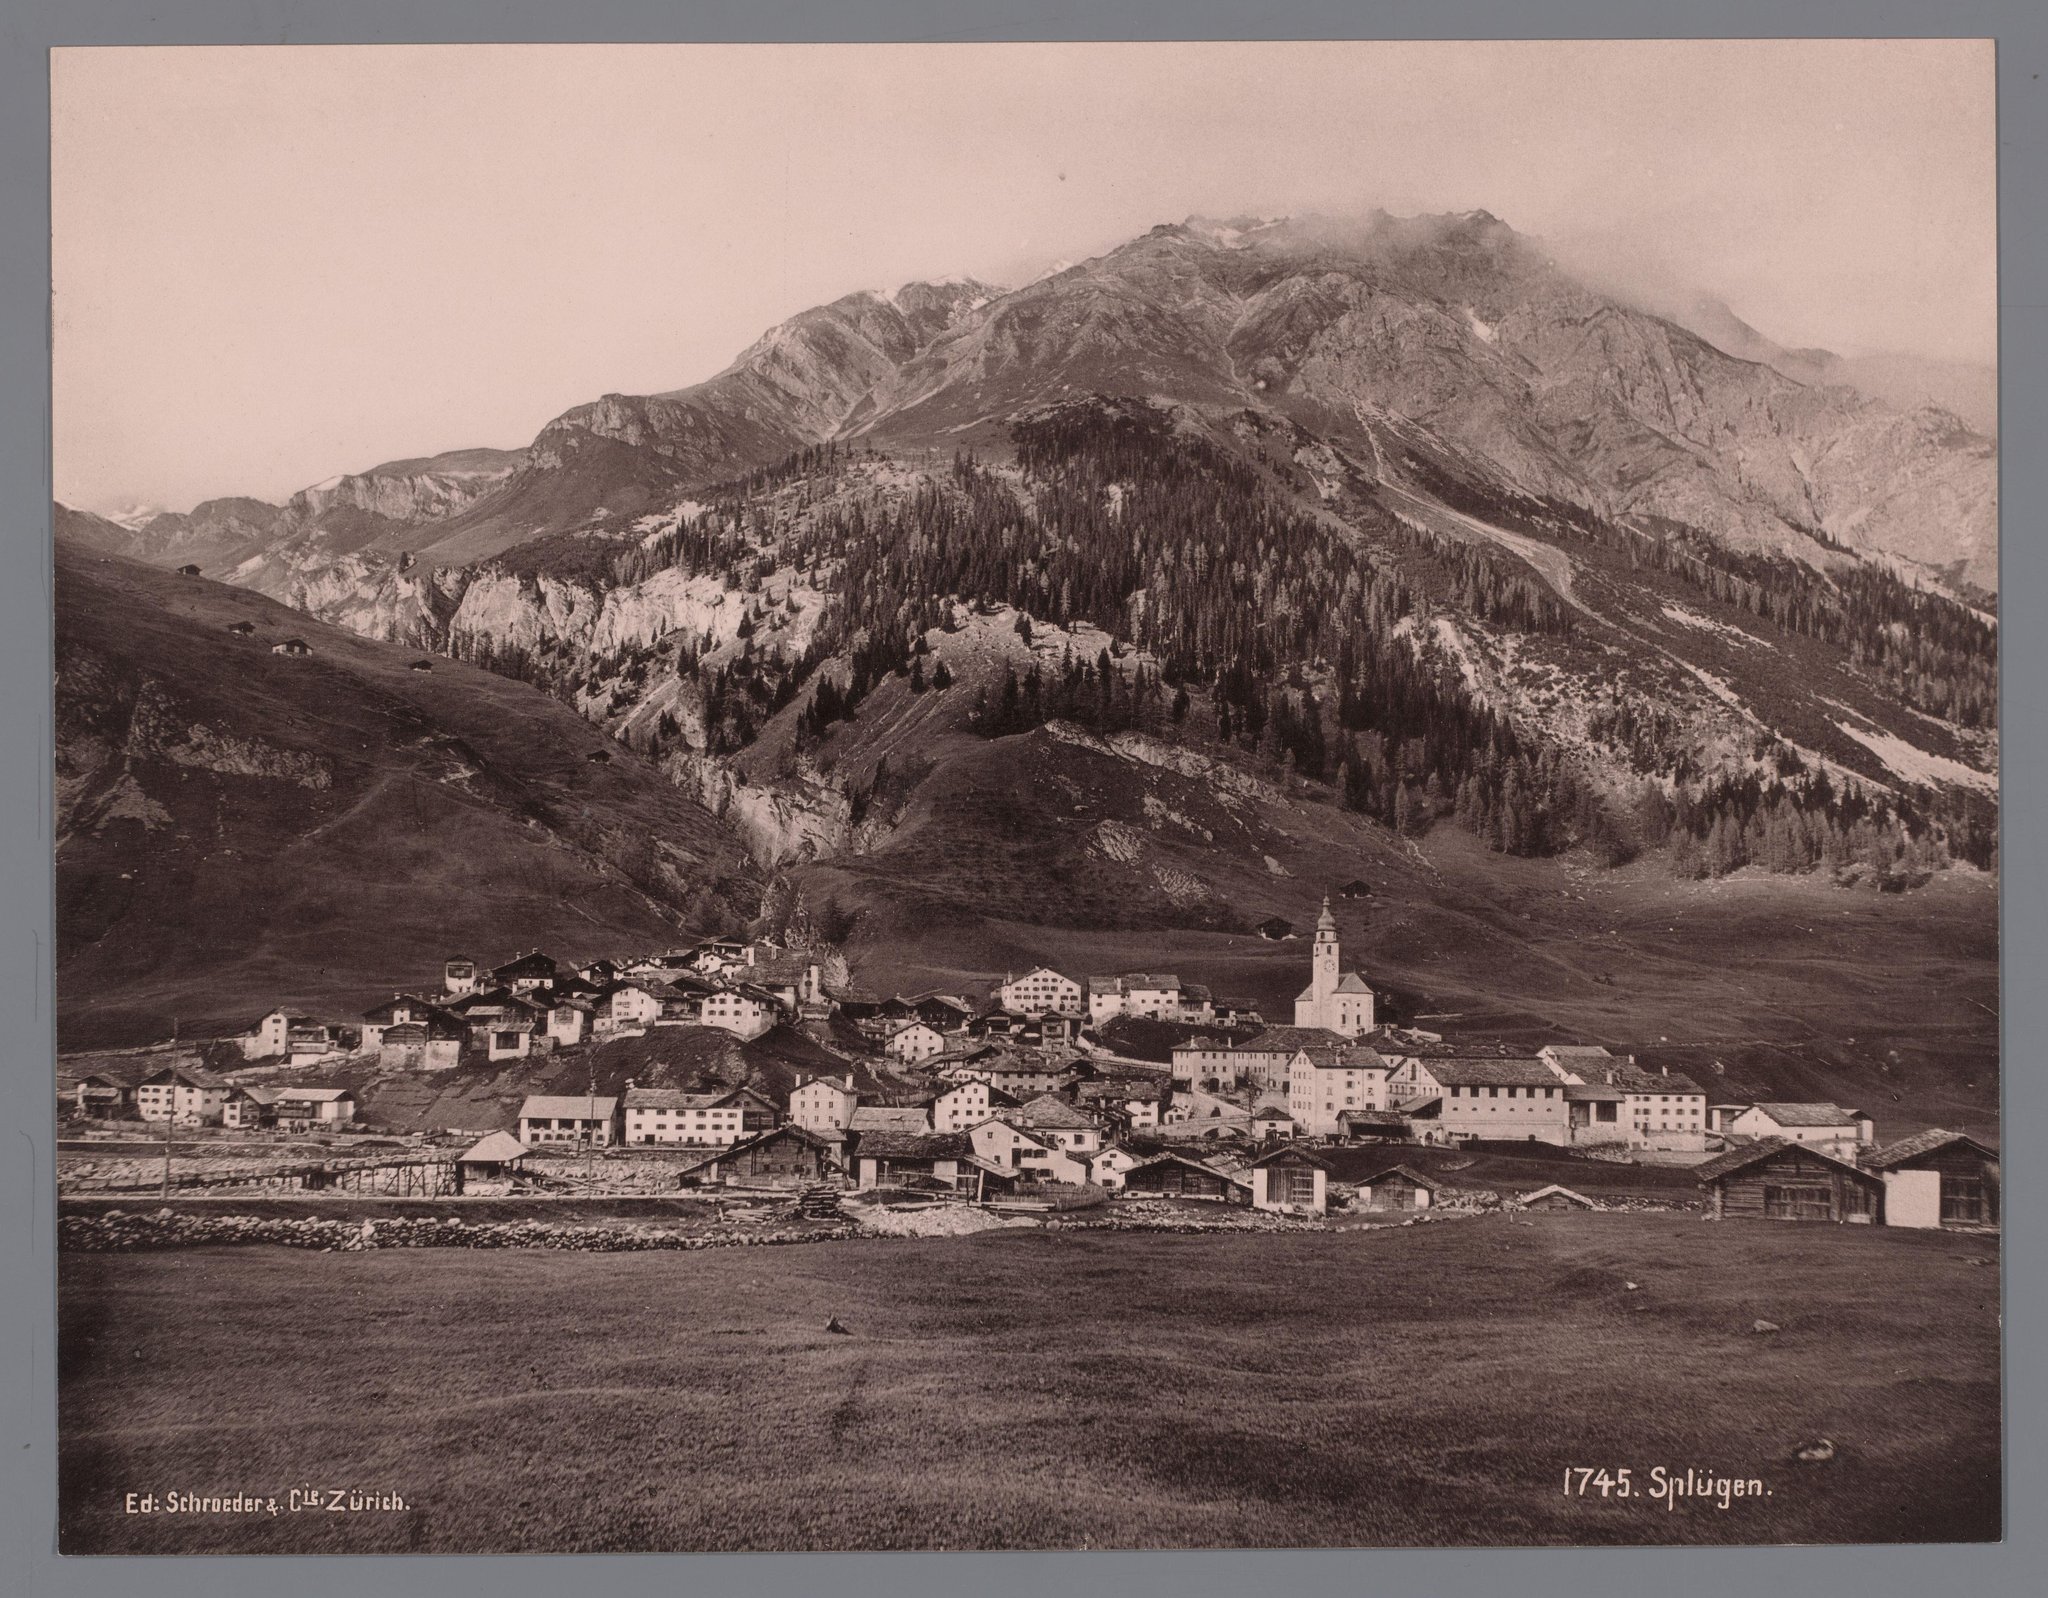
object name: photograph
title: Splügen, kanton Graubünden, Zwitserland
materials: paper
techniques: photoaquatint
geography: switzerland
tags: switzerland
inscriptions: inscription: ‘12 Juni 99’, inscription: ‘Ed: Schroeder & Cie., Zürich.’, inscription: ‘1745. Splügen’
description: Splügen is een plaats en gemeente aan de Achter-Rijn in het Zwitserse kanton Graubünden en de voornaamste plaats in het Rheinwald, Zwitserland. Het dorp ligt op 1450 m hoogte aan de voet van de Splügenpas, een pas die al sinds de Romeinse tijd gebruikt werd als verbindingsroute voor goederen naar Italië.